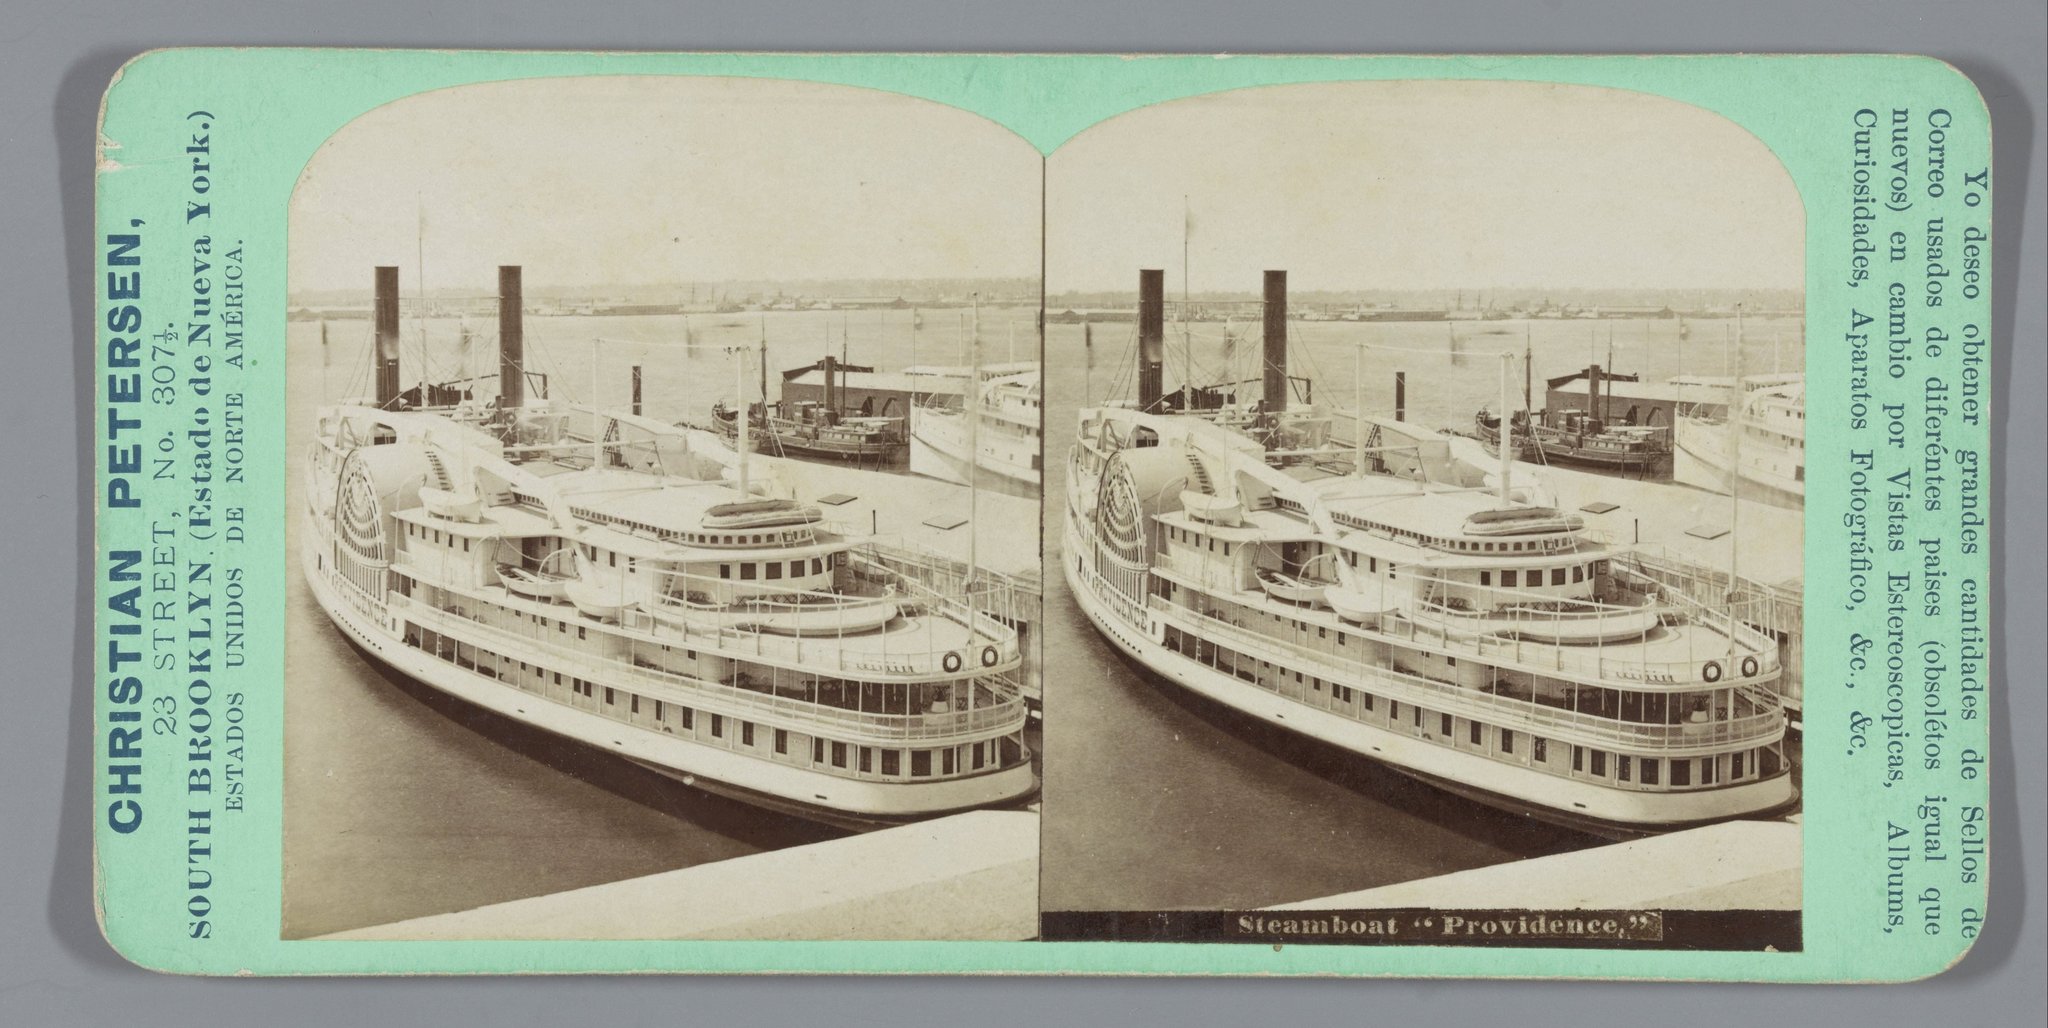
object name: stereograph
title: Gezicht op de Providence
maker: christian petersen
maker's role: fotograaf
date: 1867-1890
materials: cardboard, paper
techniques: albumen print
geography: new york city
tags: ships (in general)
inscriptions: inscription: ‘Yo deseo obtener millones de Sellos de Correo/ usados de differéntes paises (obsolétos igual que nuevos)/ en cambio por Vistas Estereoscopias, Albums, Curiosidades,/ Aparatos Fotográfico, Relojes de Música, &c.’